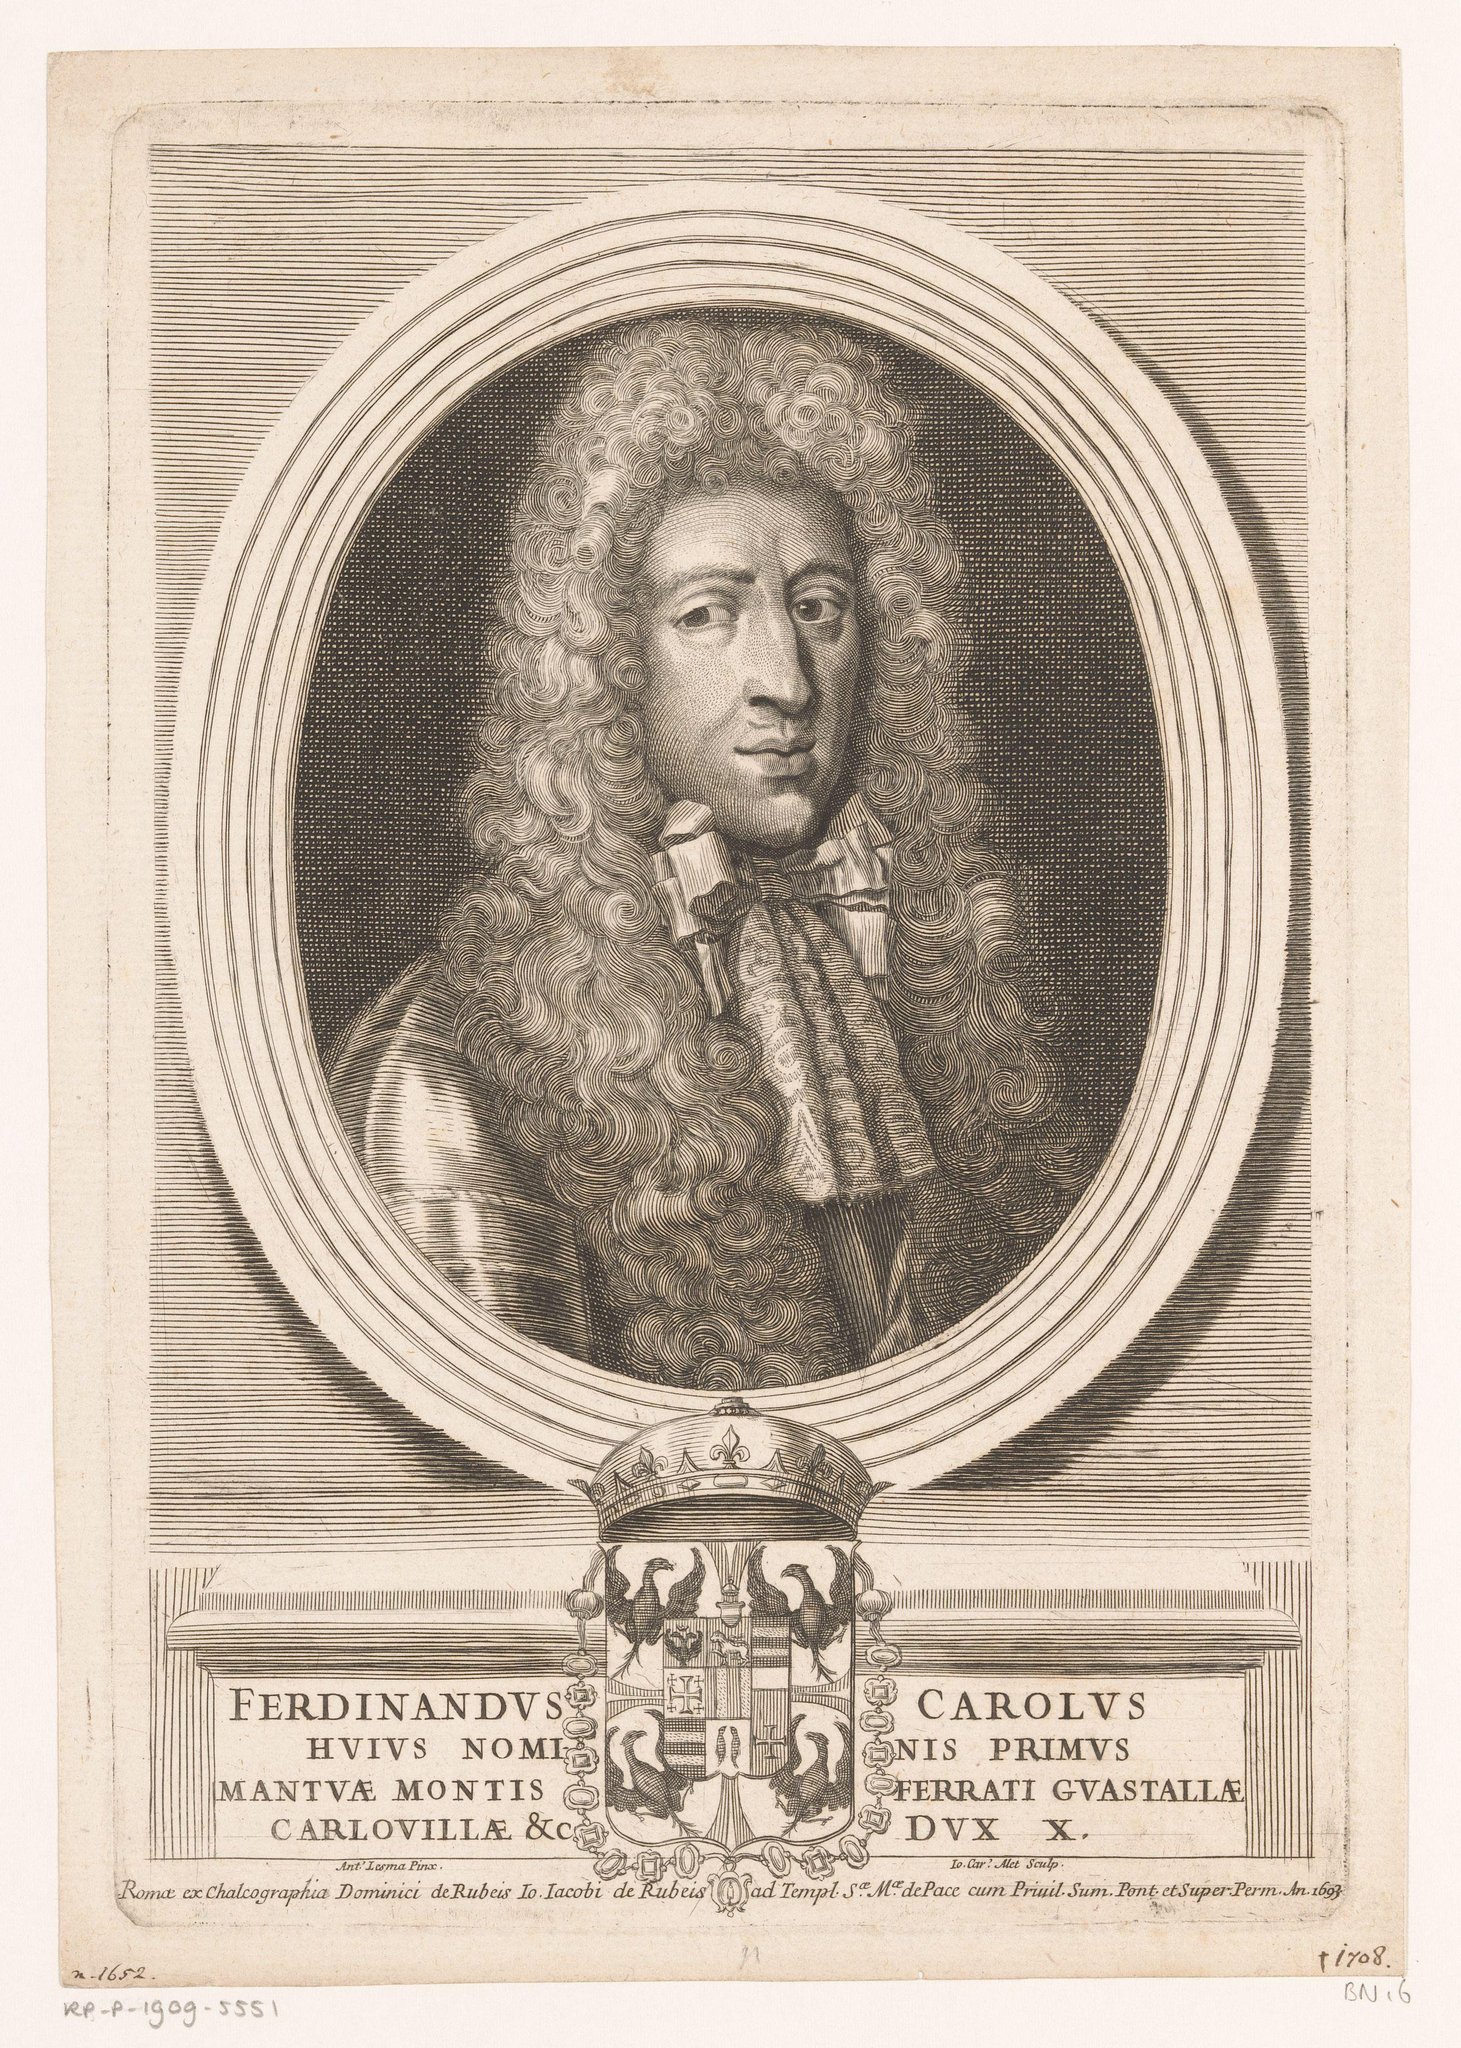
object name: print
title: Portret van Ferdinando Carlo Gonzaga, graaf van Mantua en Montferrat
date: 1693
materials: paper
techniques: engraving, etching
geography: rome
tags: historical persons, armorial bearing, heraldry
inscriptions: inscription: ‘n. 1652./†1708.’, collector's mark: Lugt 2228